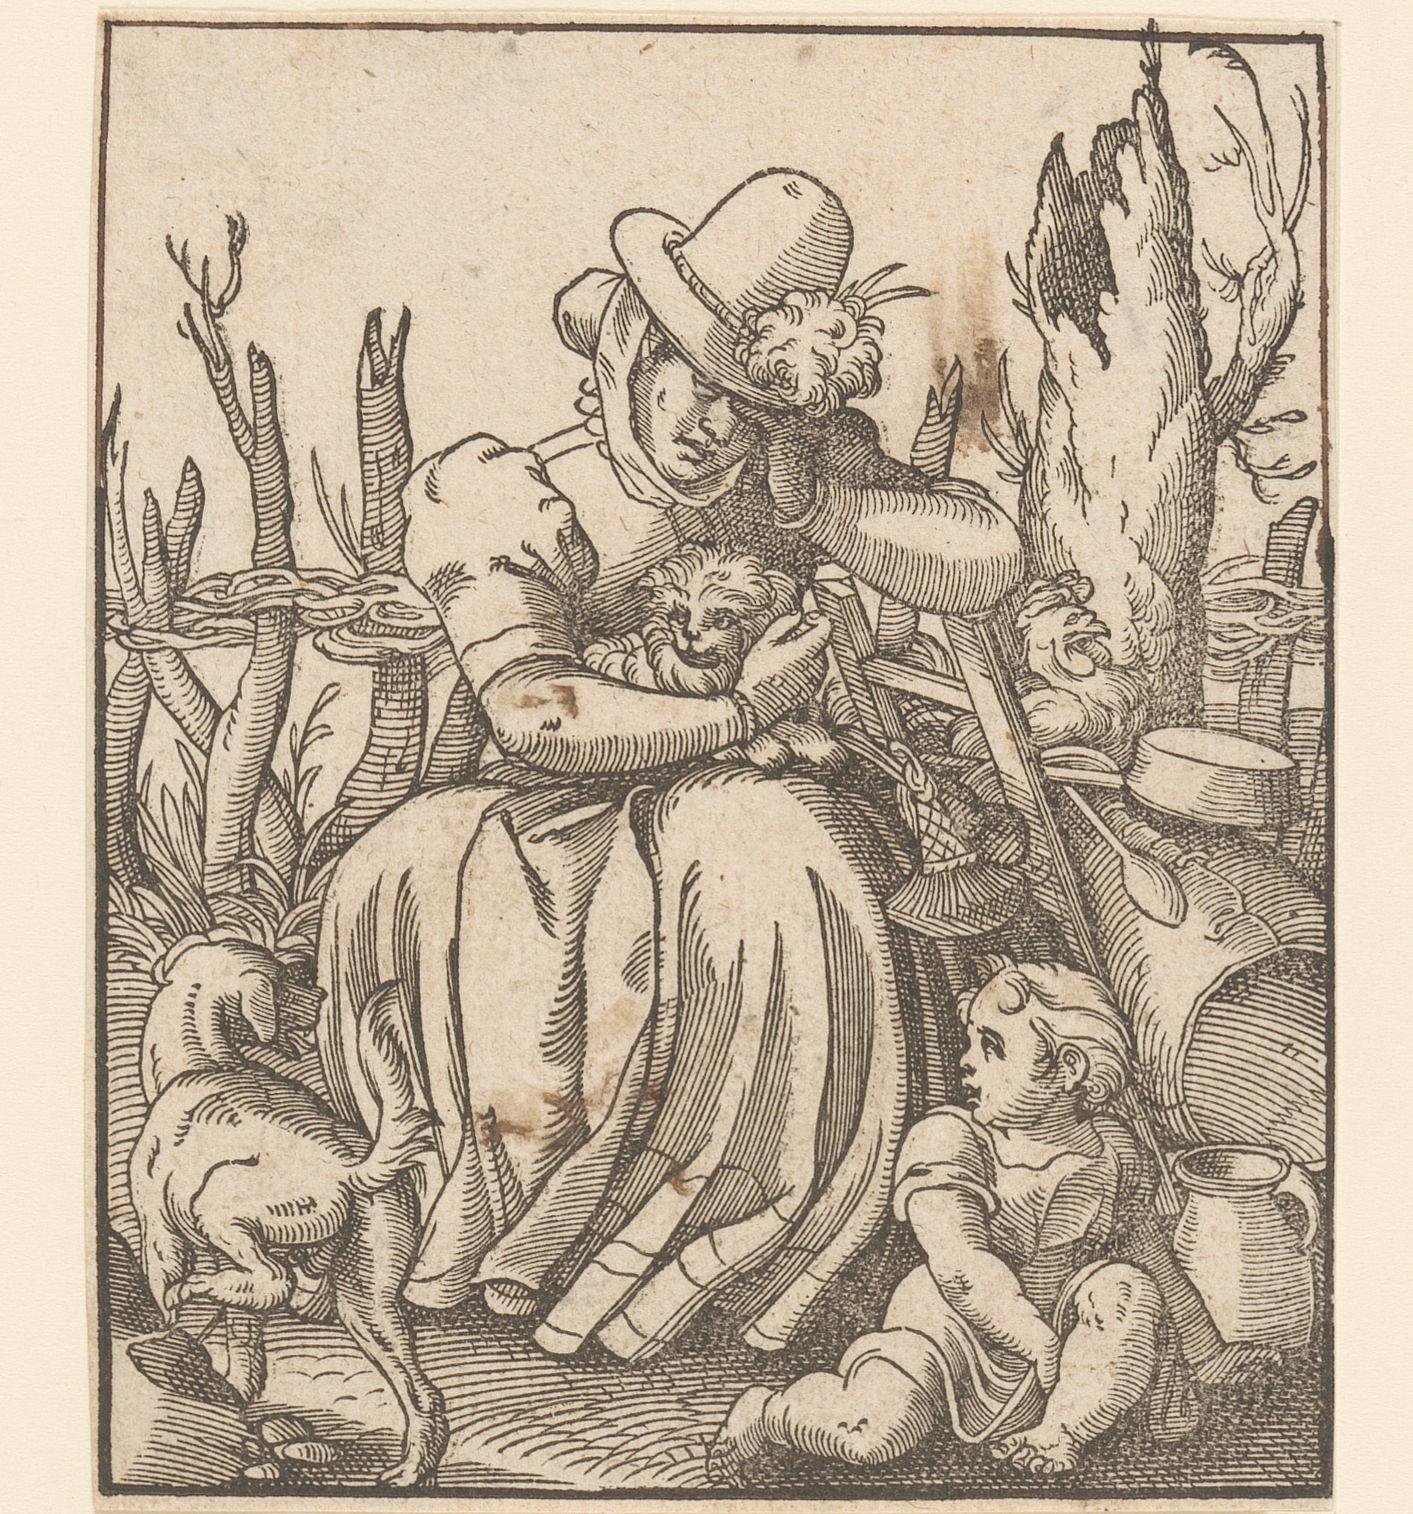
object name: print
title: Slapende vrouw met kind, honden en een haan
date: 1580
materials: paper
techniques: woodcut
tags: toddler, adult woman, sleeping; unconsciousness, dog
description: Prent ook gebruikt in: Amman, Jost. Kunstbüchlein. Frankfurt am Main: Feyerabend, 1580.